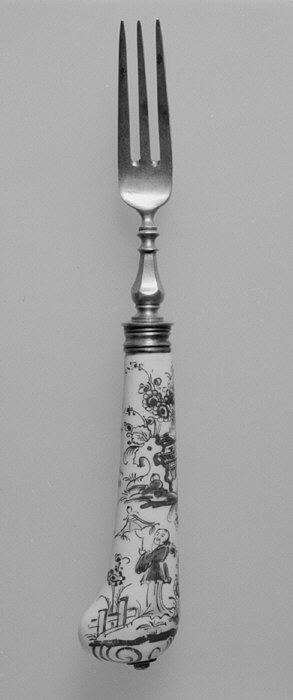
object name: knife and fork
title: Fork and knife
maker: saint-cloud factory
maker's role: factory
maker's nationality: french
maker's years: 1693-1766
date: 1740-1750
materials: porcelain, silver, steel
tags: men,flowers